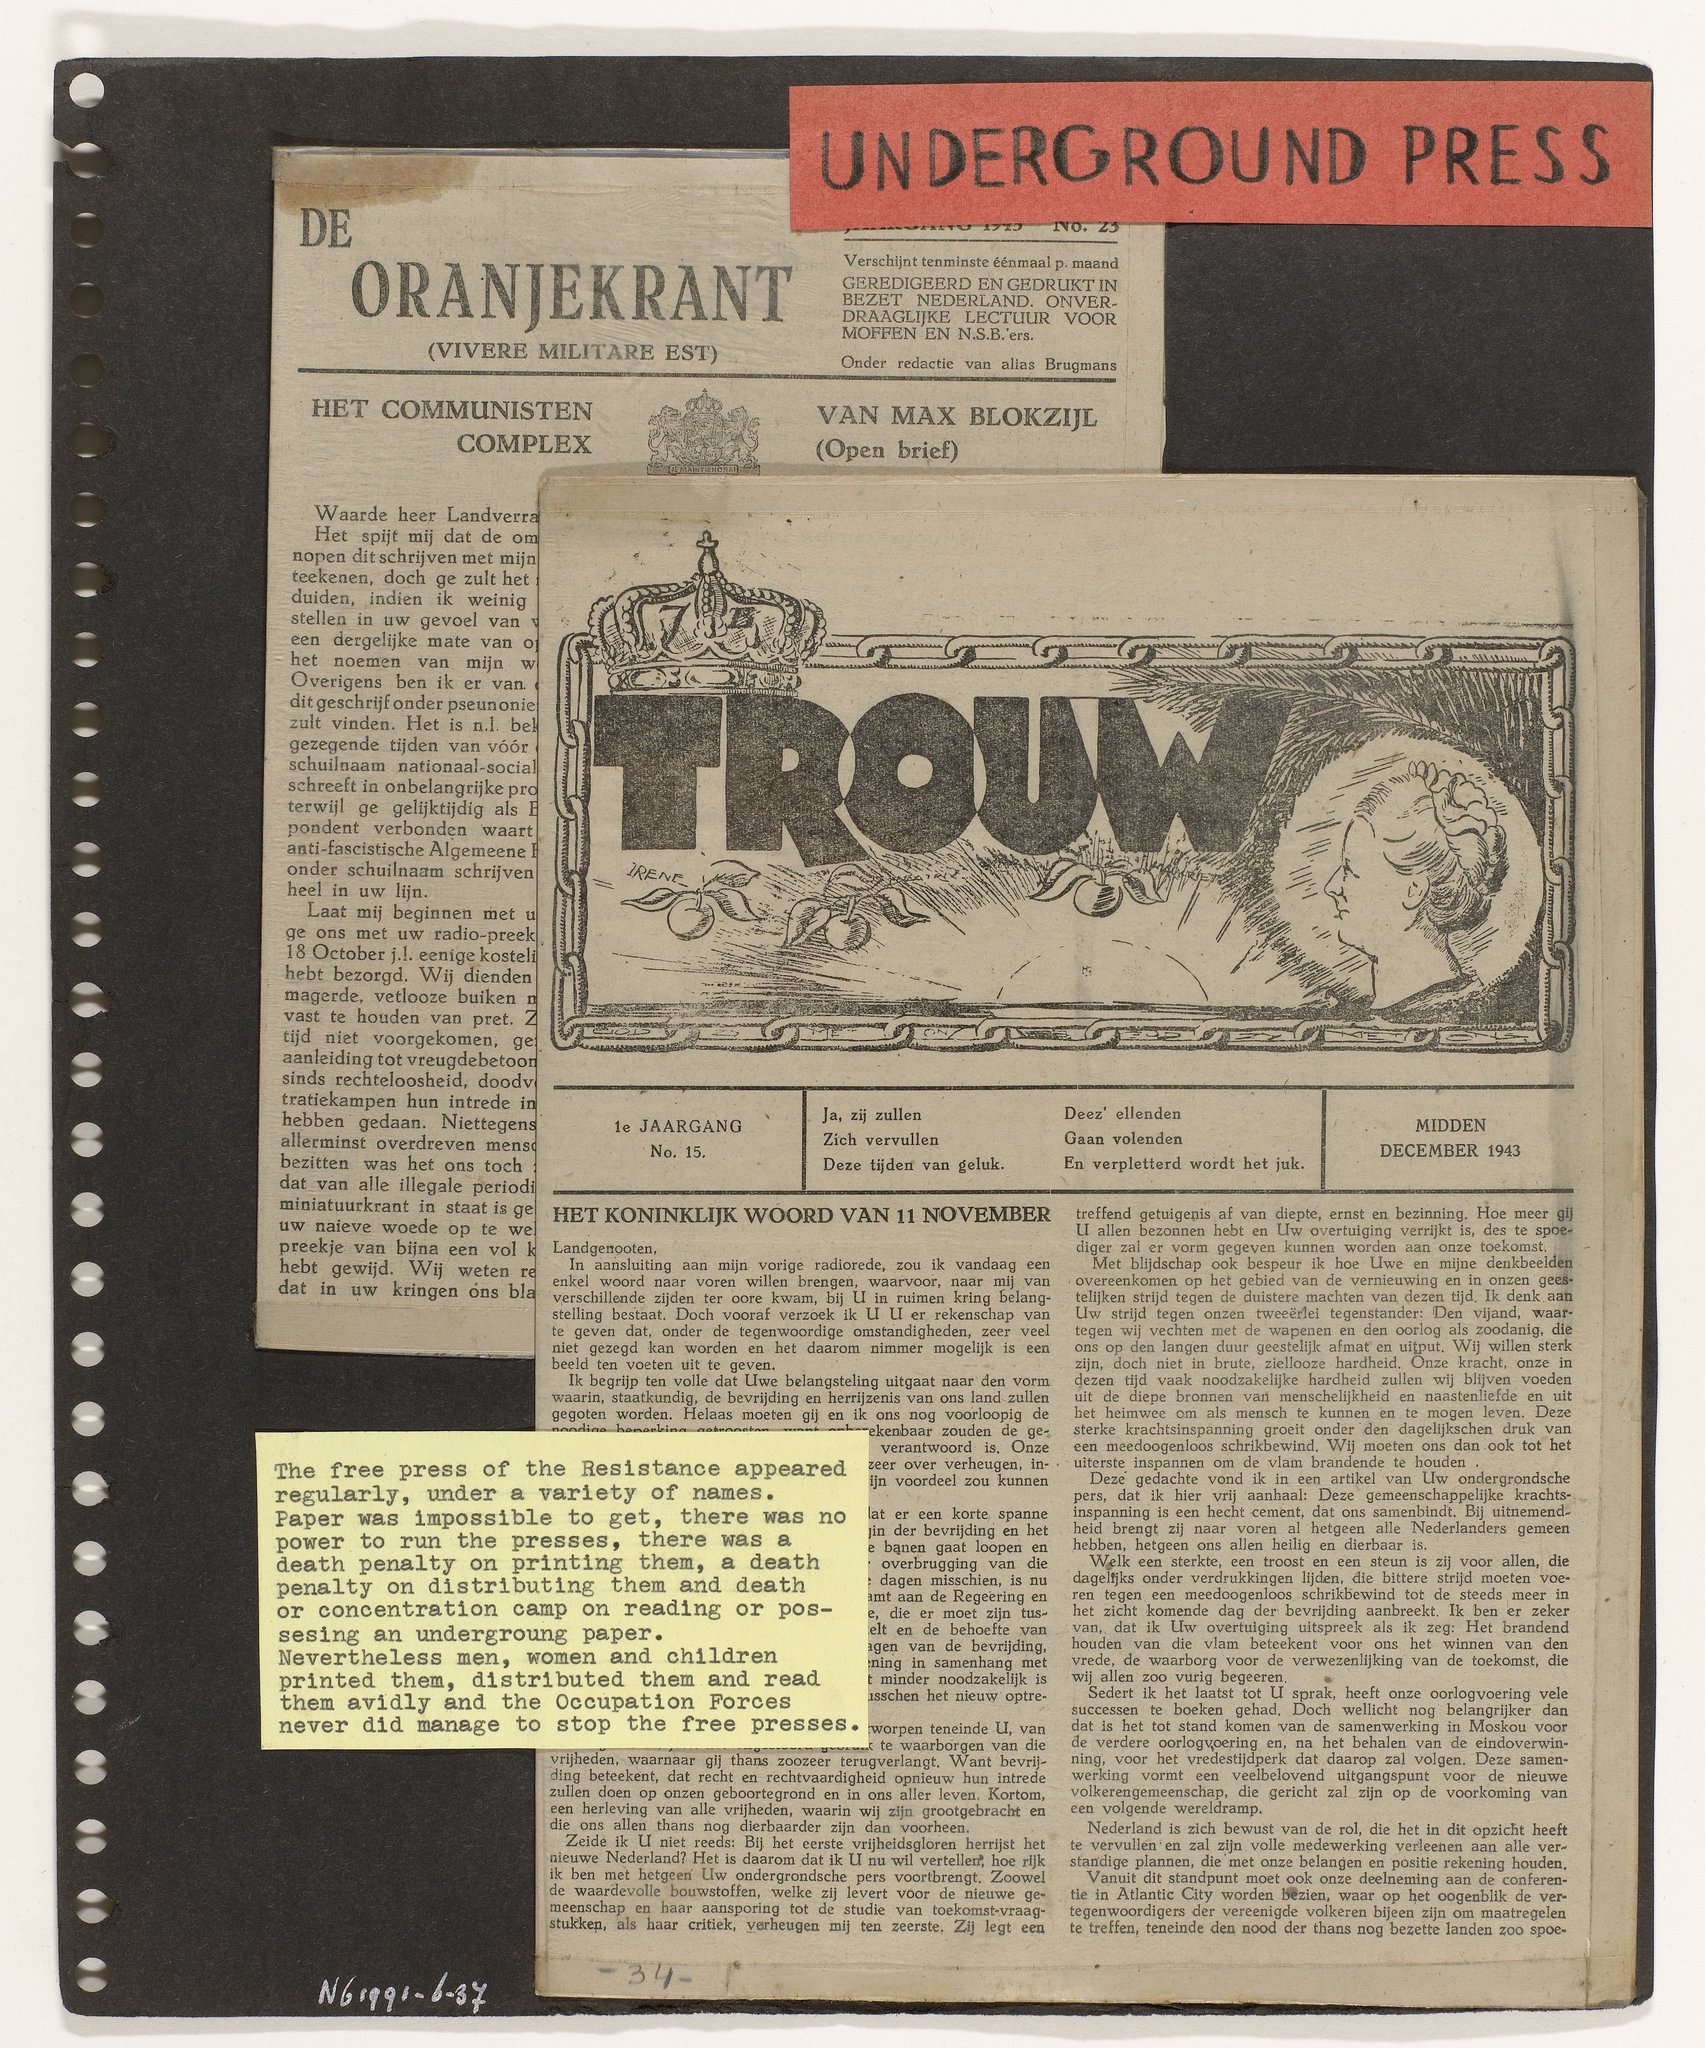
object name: newspaper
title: Foto en collageboek 'De Verborgen Camera'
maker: Anonymous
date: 1943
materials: paper, plastic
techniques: printing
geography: netherlands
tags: amsterdam, tonny van renterghem, fritz kahlenberg, underground movement, partisans, newspaper, news-sheet, netherlands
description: Twee illegale kranten: Trouw van midden december 1943 en De Oranjekrant, jaargang 1943, no. 23.